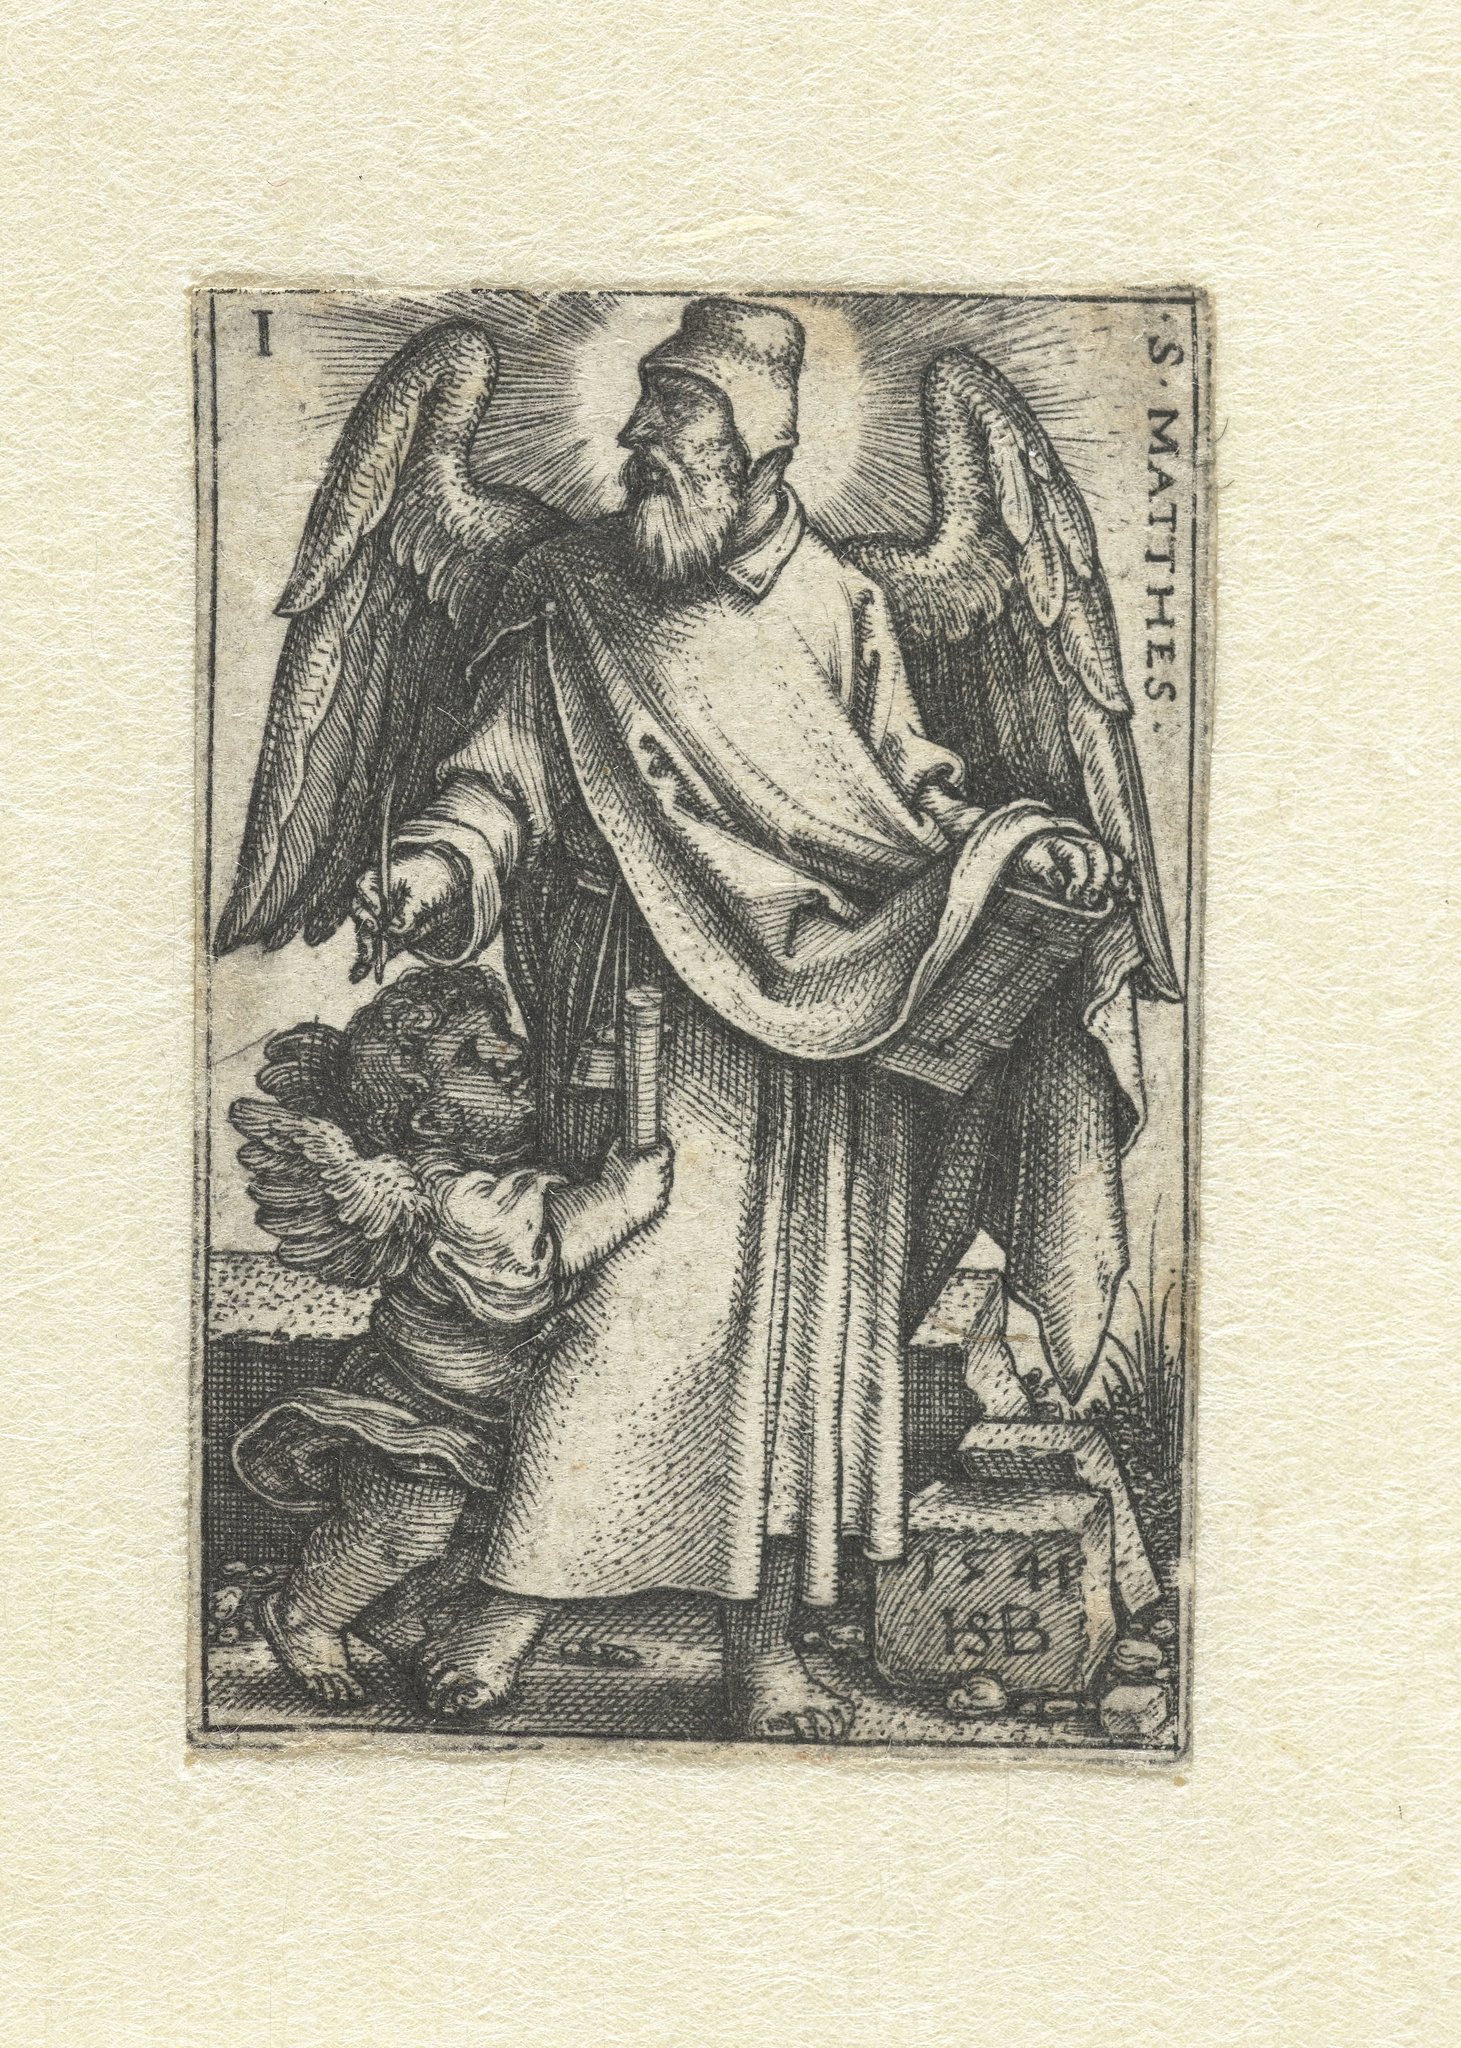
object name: print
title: S. Matthes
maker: hans sebald beham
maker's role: designer, draughtsman, print maker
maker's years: 1500-1550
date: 1541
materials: paper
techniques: engraving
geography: frankfurt am main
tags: the apostle and evangelist matthew (mattheus); possible attributes: angel, axe, book, halberd, pen and inkhorn, purse, scroll, square, sword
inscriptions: date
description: De vier Evangelisten in deze serie prenten zijn afgebeeld met vleugels, een beeldtaal die teruggaat op vroegchristelijke voorstellingen waar ze werden voorgesteld als gevleugelde wezens.